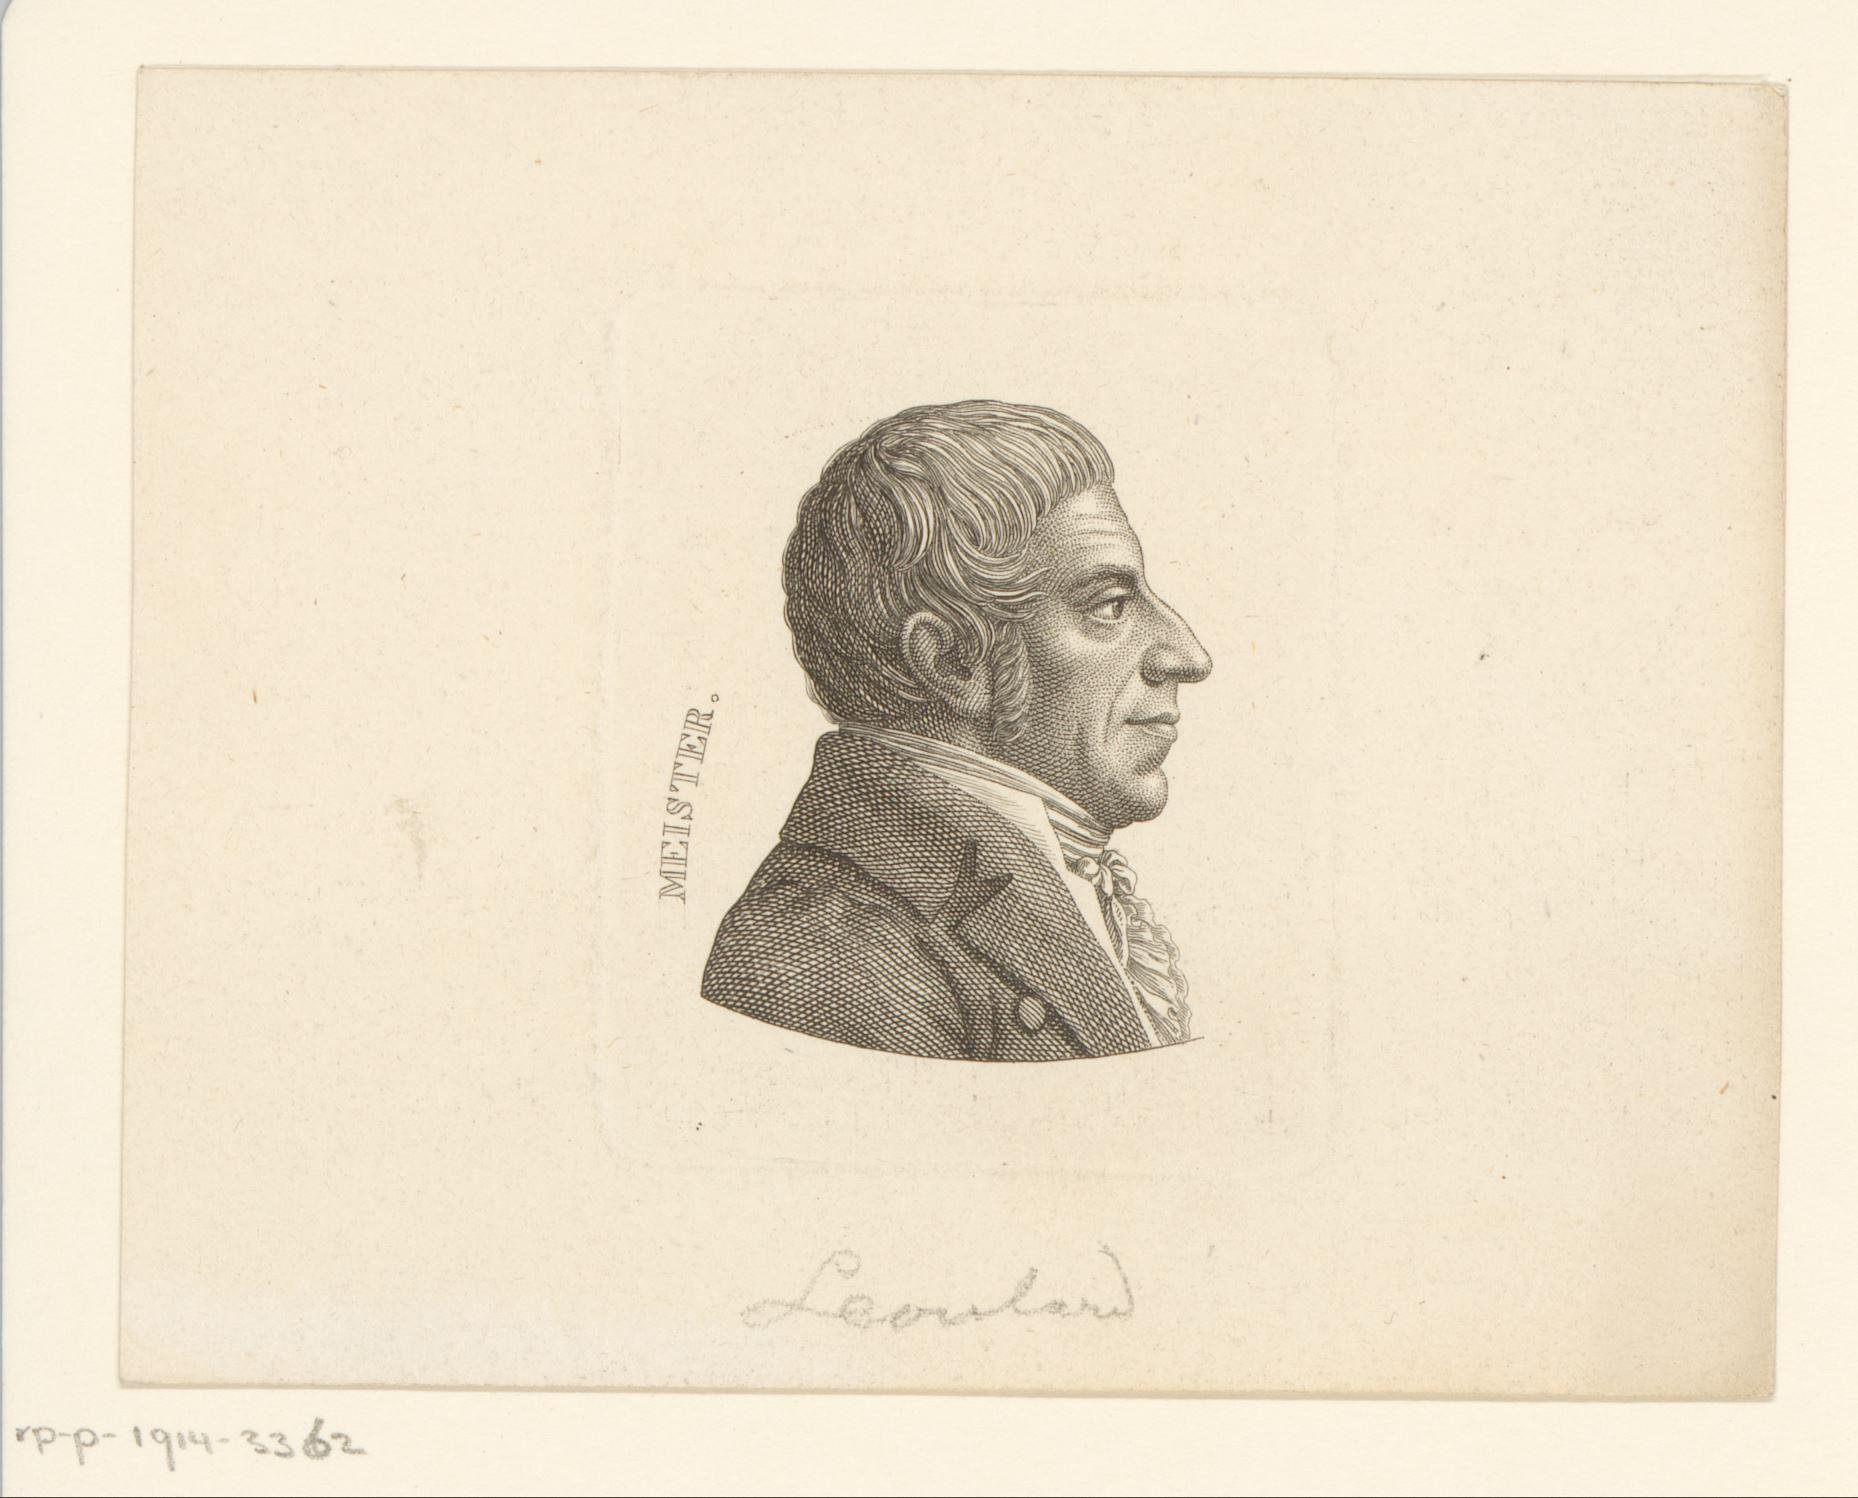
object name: print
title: Portret van Georg Jacob Friedrich Meister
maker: ernst ludwig riepenhausen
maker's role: print maker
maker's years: 1765-1840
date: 1775-1840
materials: paper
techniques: engraving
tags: historical persons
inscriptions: collector's mark: Lugt 2228, name